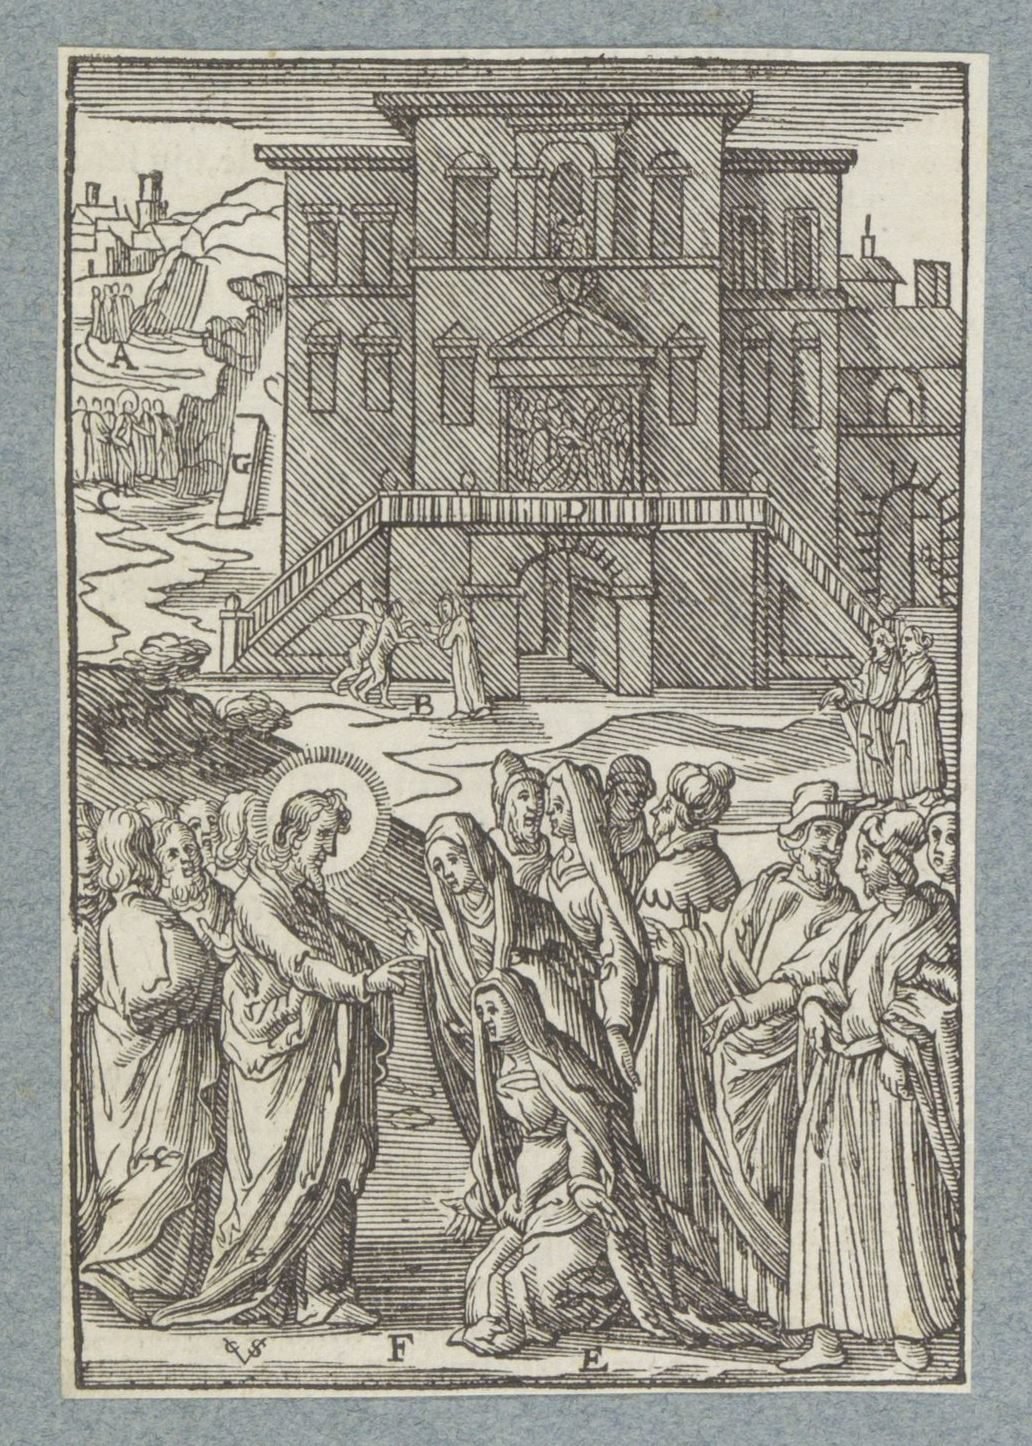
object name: album leaf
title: Aankomst van Christus in Betanië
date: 1629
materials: paper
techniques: letterpress printing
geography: amsterdam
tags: the sisters of the dying lazarus send to christ for help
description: De prent is afkomstig uit een van de uitgaven van P.J. Paets uit Amsterdam. Ze wordt voor het eerst gebruikt in: Der Zielen Lust-hof. Leuven, I.Jacbosz voor P.J. Paets [= Amsterdam, P.J. Paets], 1629. De voorstelling is gekopieerd naar een prent van Johannes Wierix voor: Nadal, Jerónimo. Evangelicae Historiae Imagines. Antwerpen, M. Nutius, 1593.